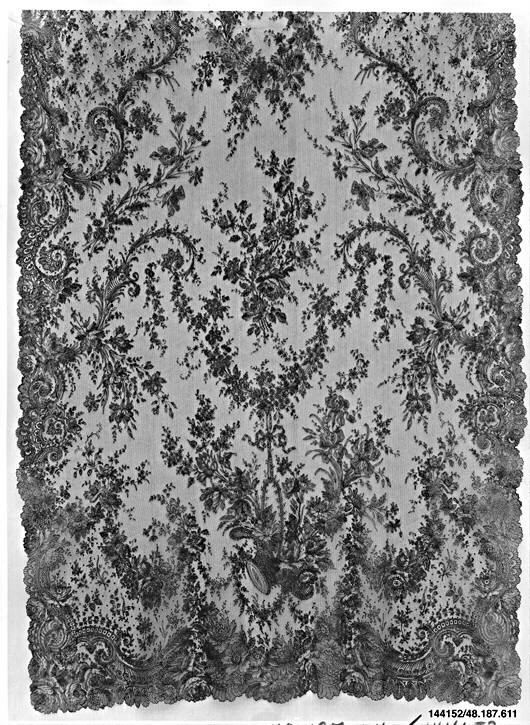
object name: scarf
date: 1851-1875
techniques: lace